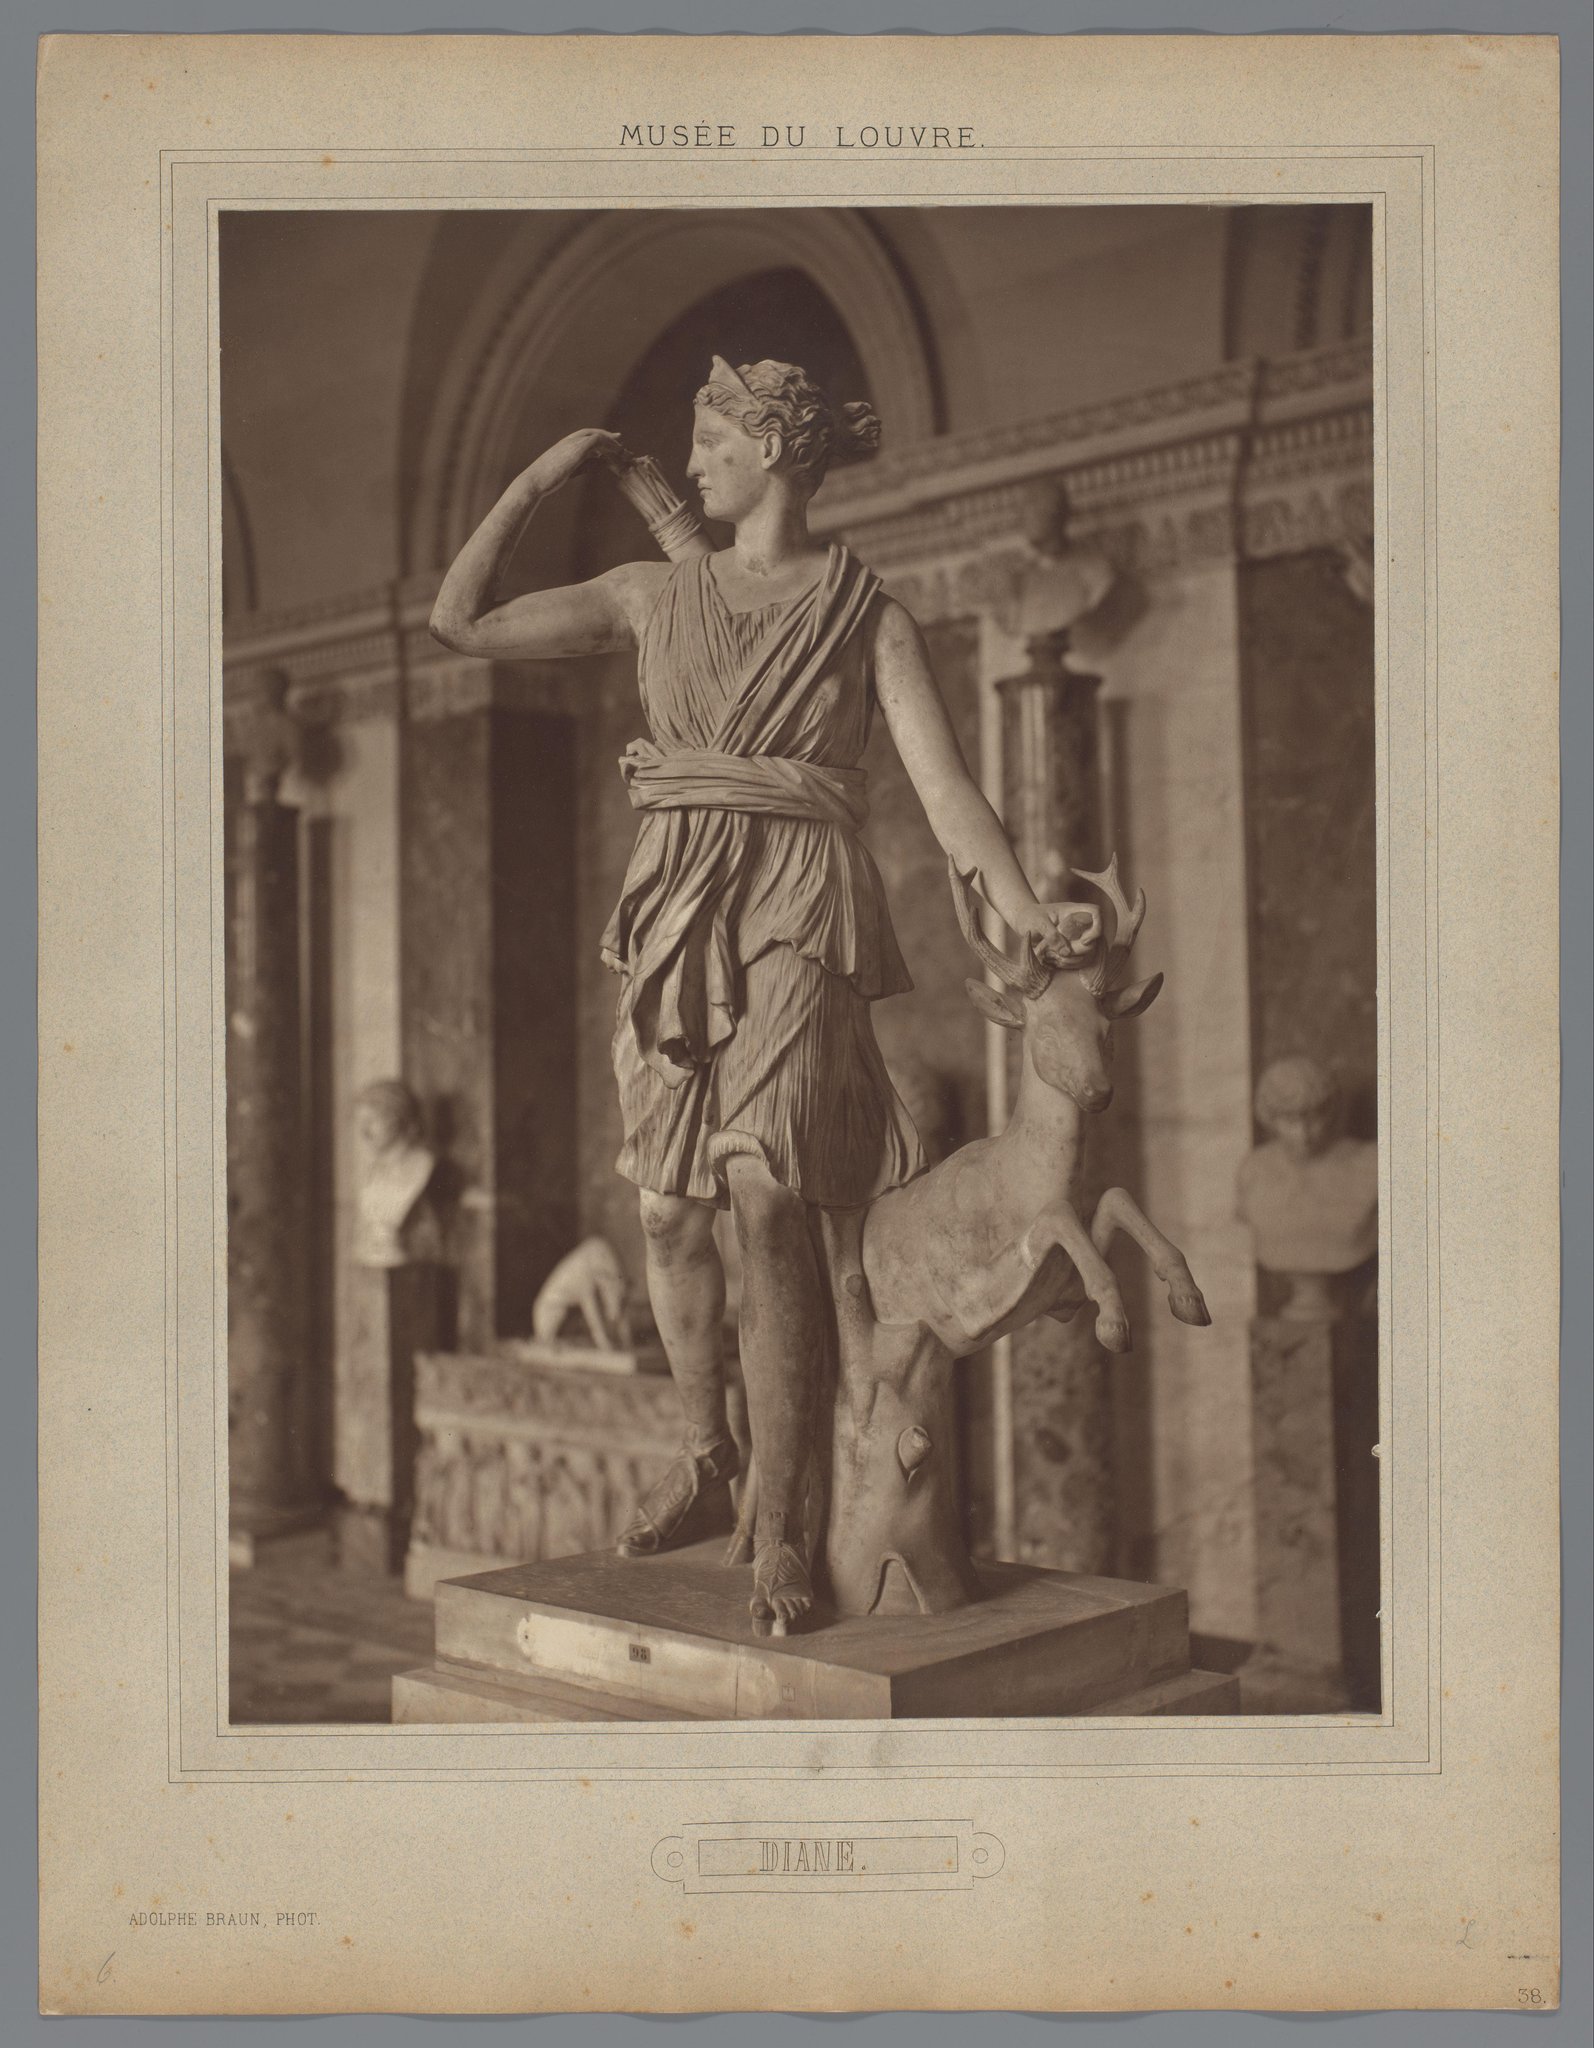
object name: photograph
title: Sculptuur van Diana (coll. Louvre)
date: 1880-1900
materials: cardboard, paper, photographic support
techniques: carbon print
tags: musée du louvre